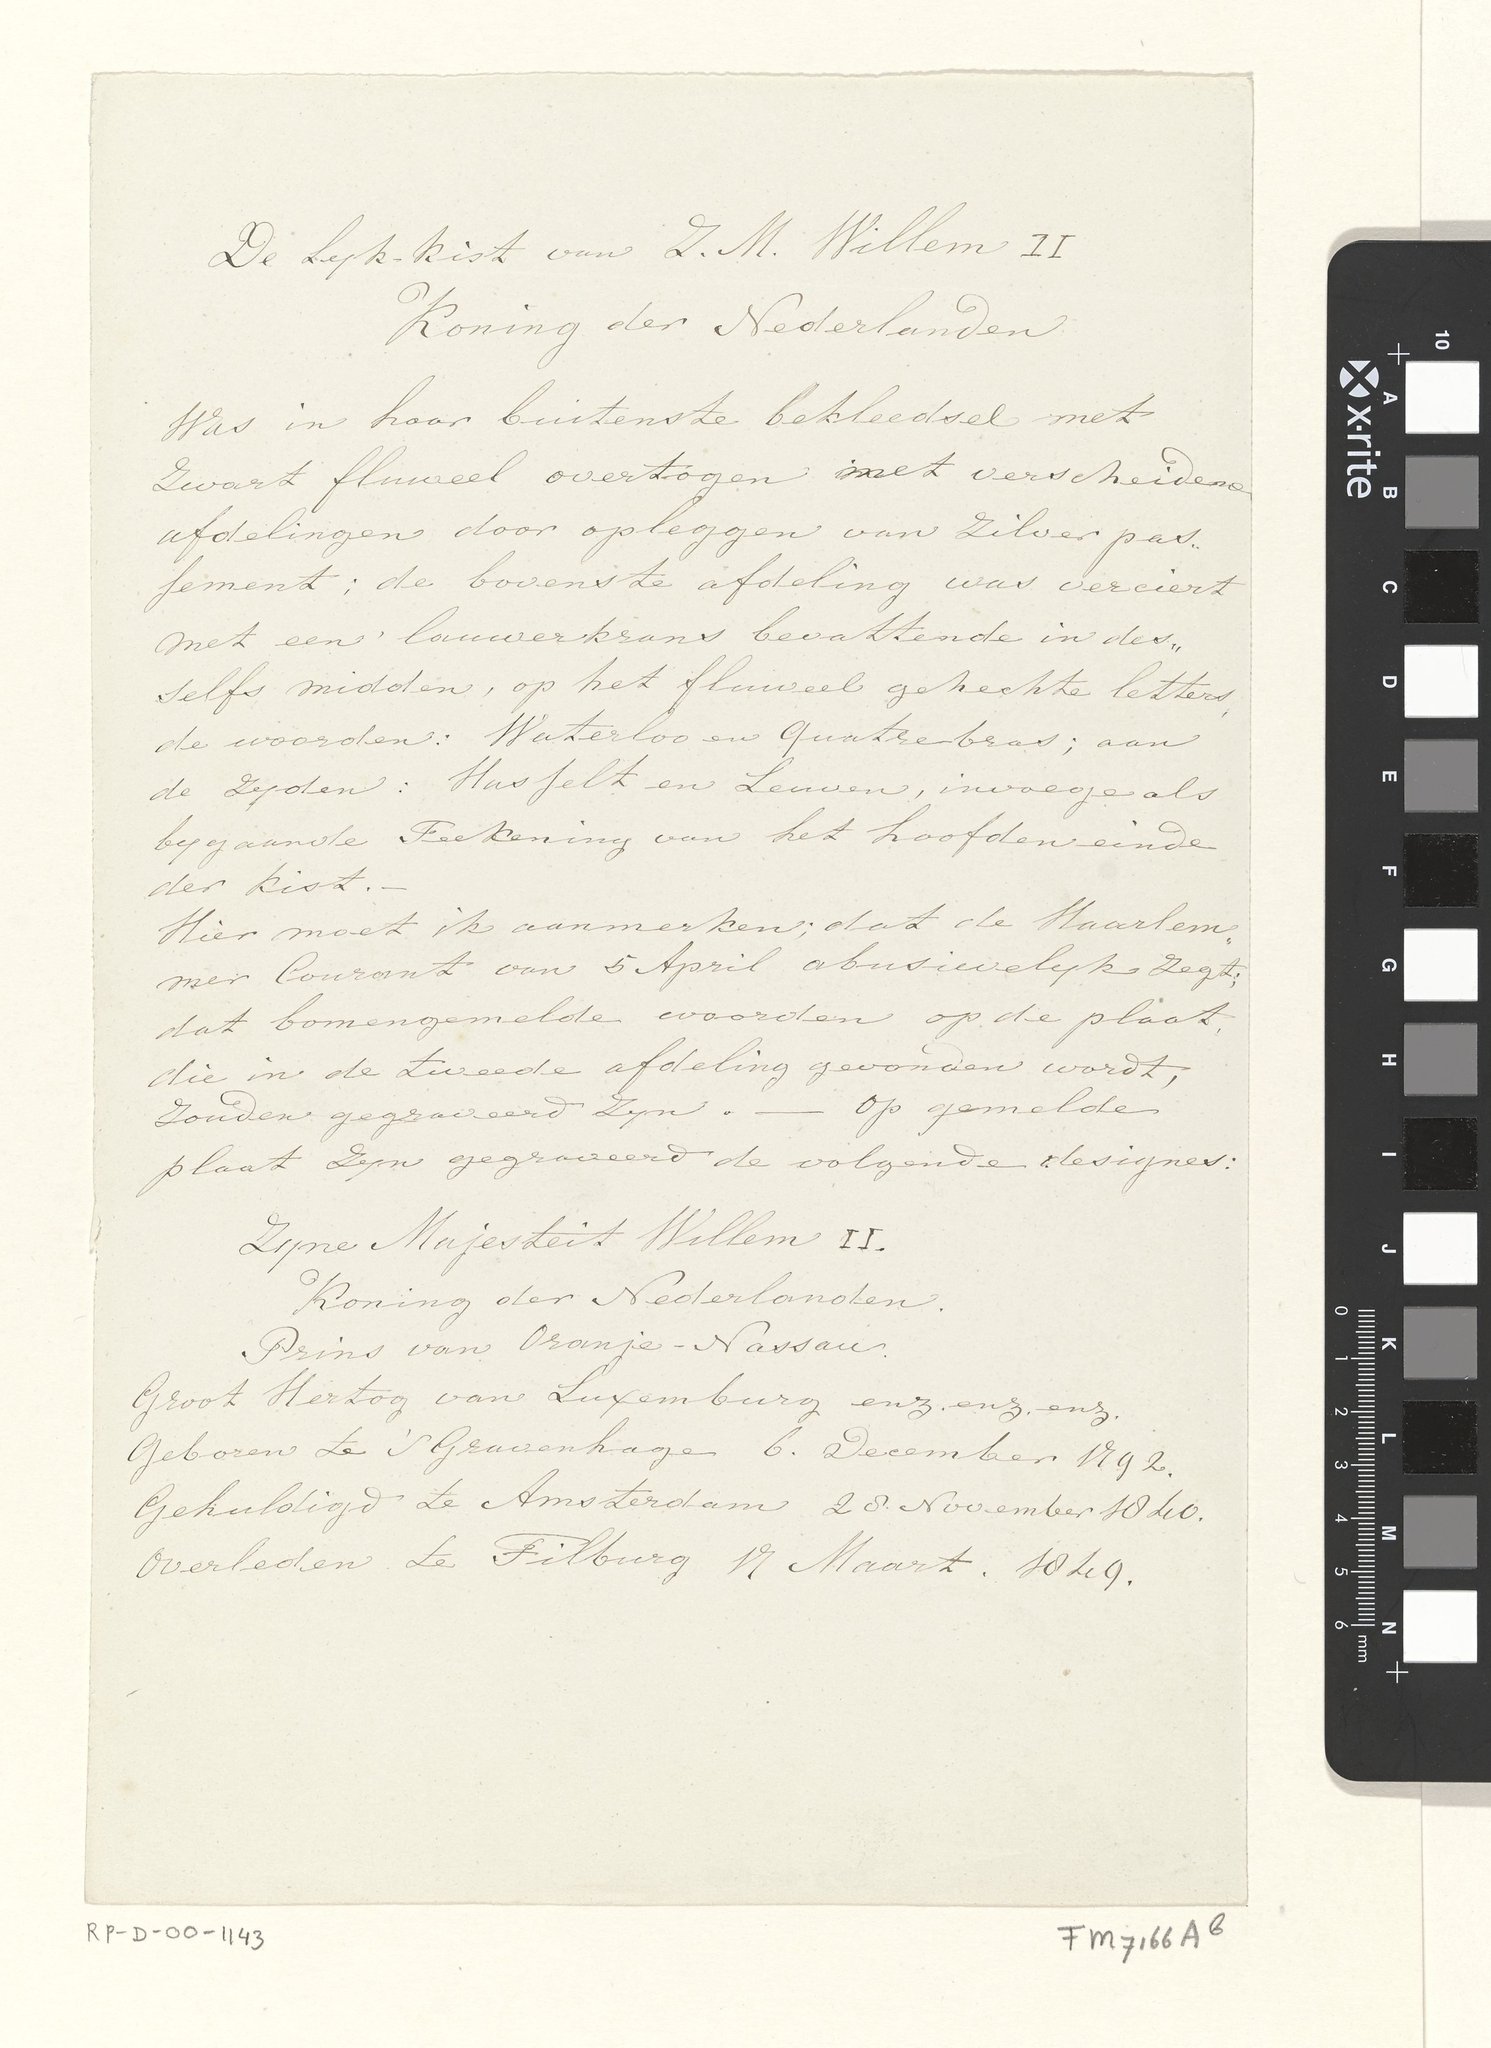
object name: manuscript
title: Beschrijving van de lijkkist van koning Willem II, 1849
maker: Anonymous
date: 1849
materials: paper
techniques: pen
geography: netherlands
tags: william ii of the netherlands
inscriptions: collector's mark: Lugt 2228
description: Handgeschreven beschrijving van de lijkkist van koning Willem II, bij zijn begrafenis op 4 april 1849 te Delft.